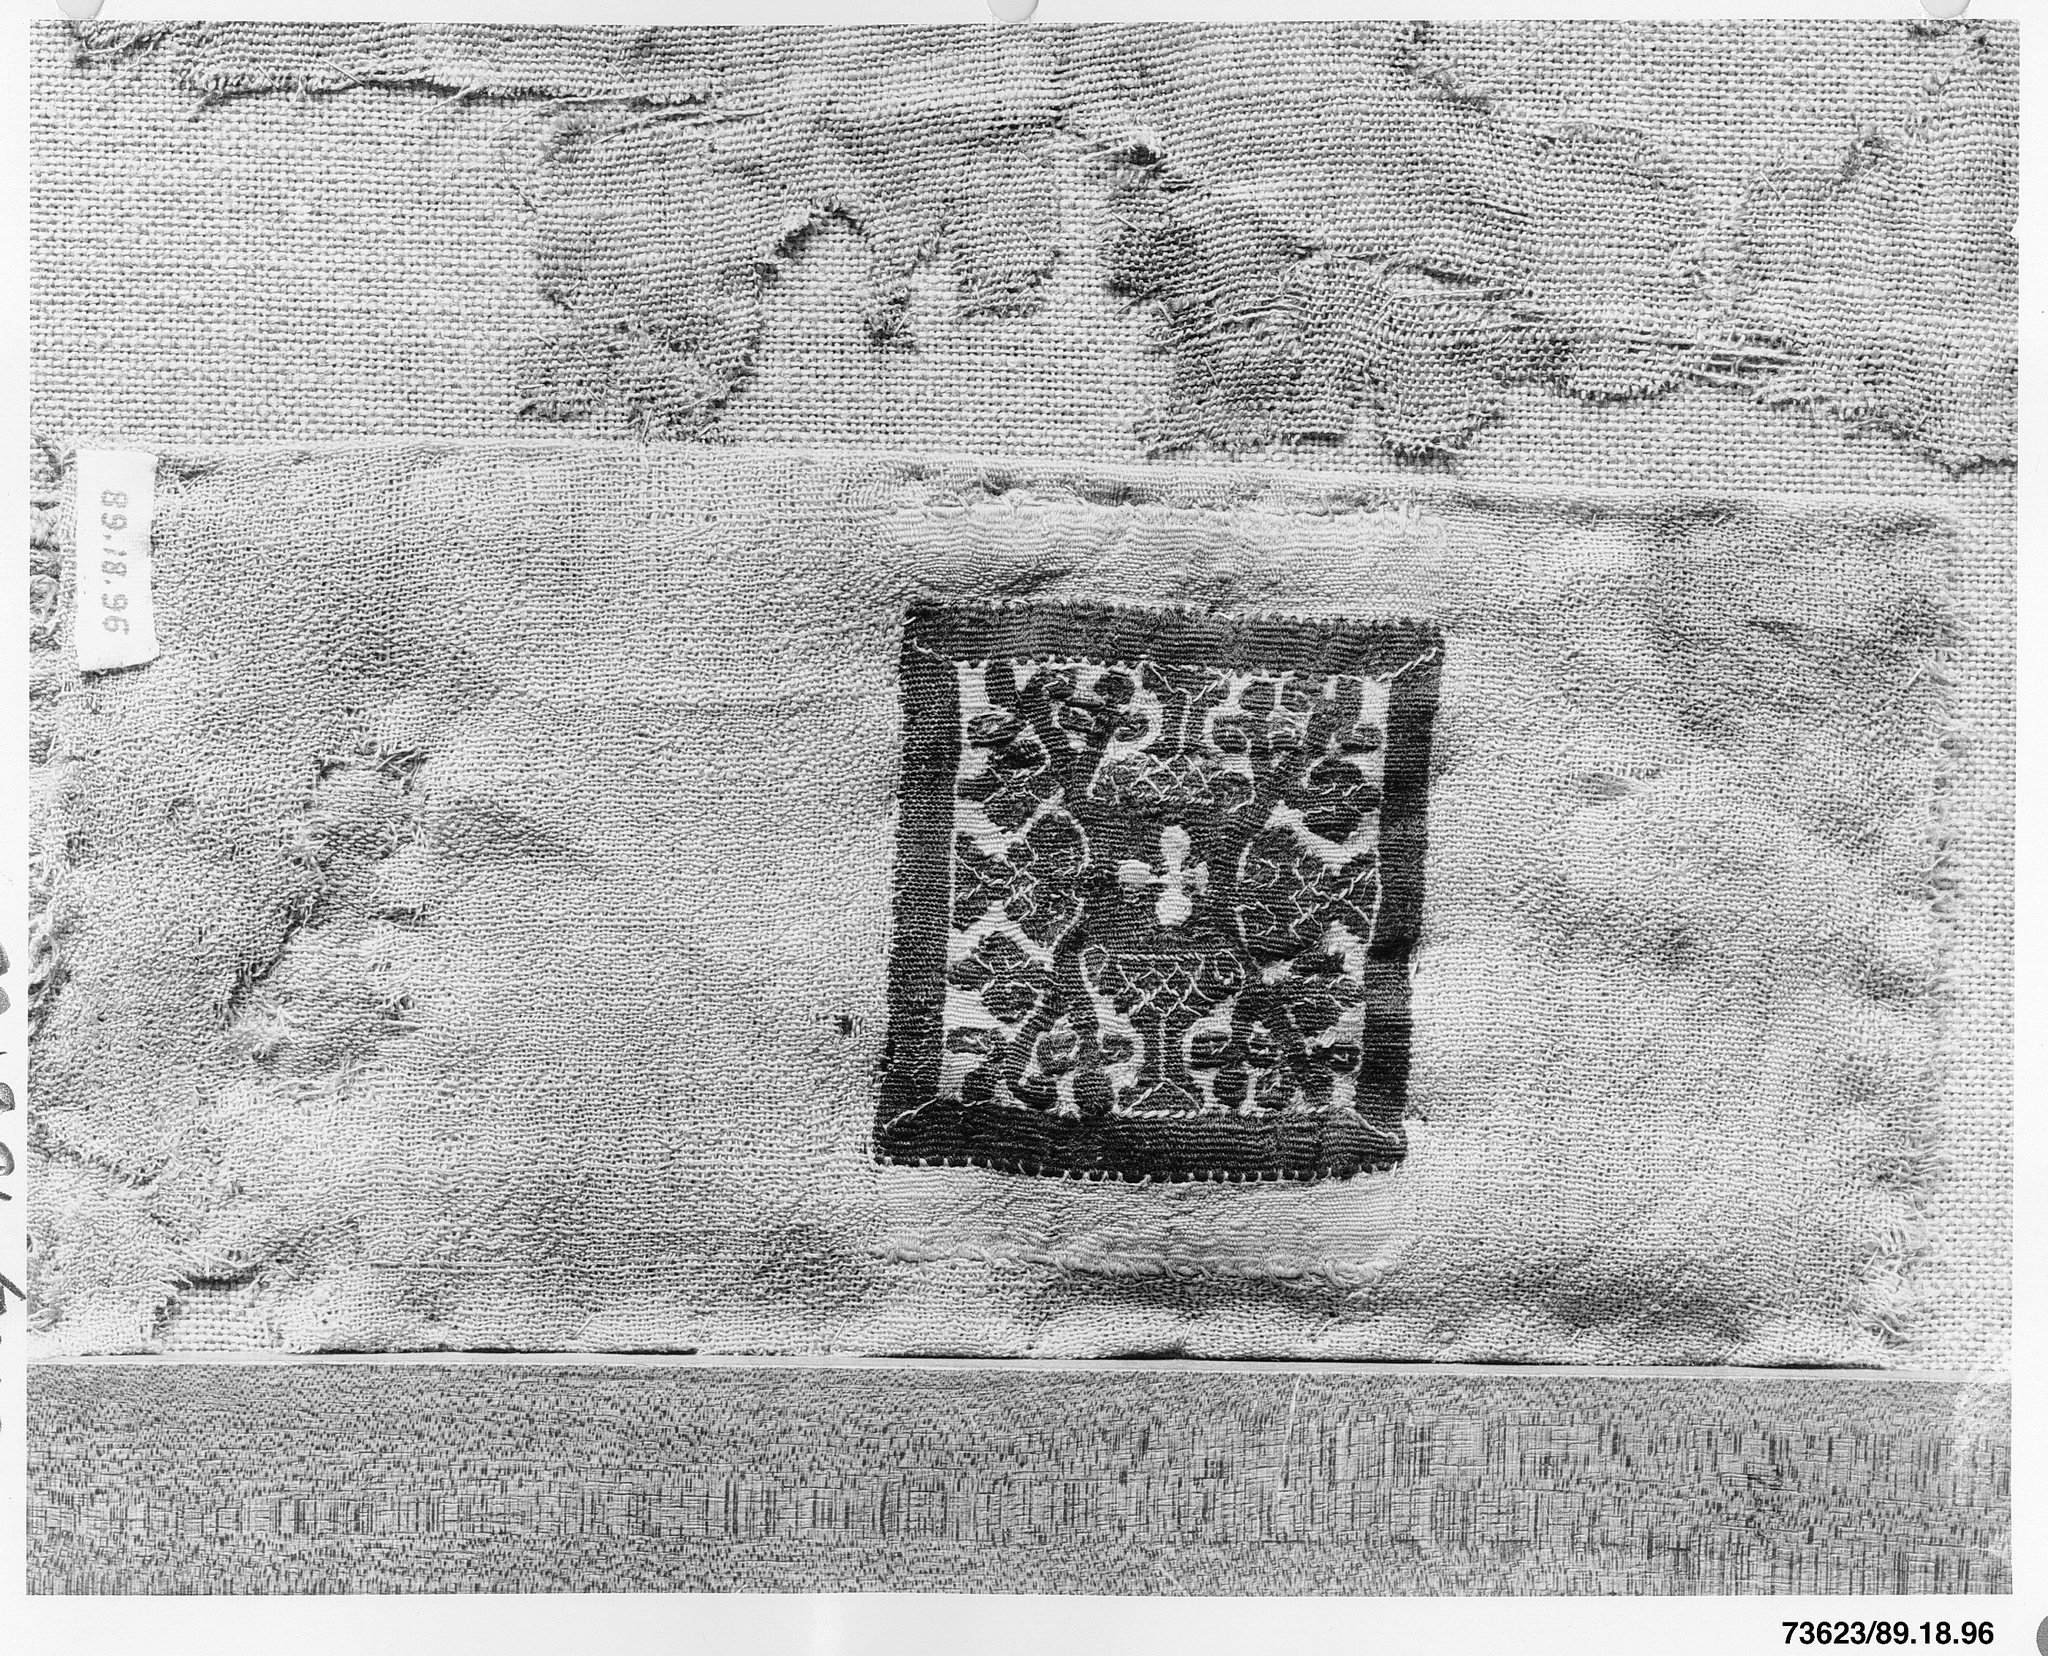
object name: textile fragment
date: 301-500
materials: linen, wool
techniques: weave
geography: egypt